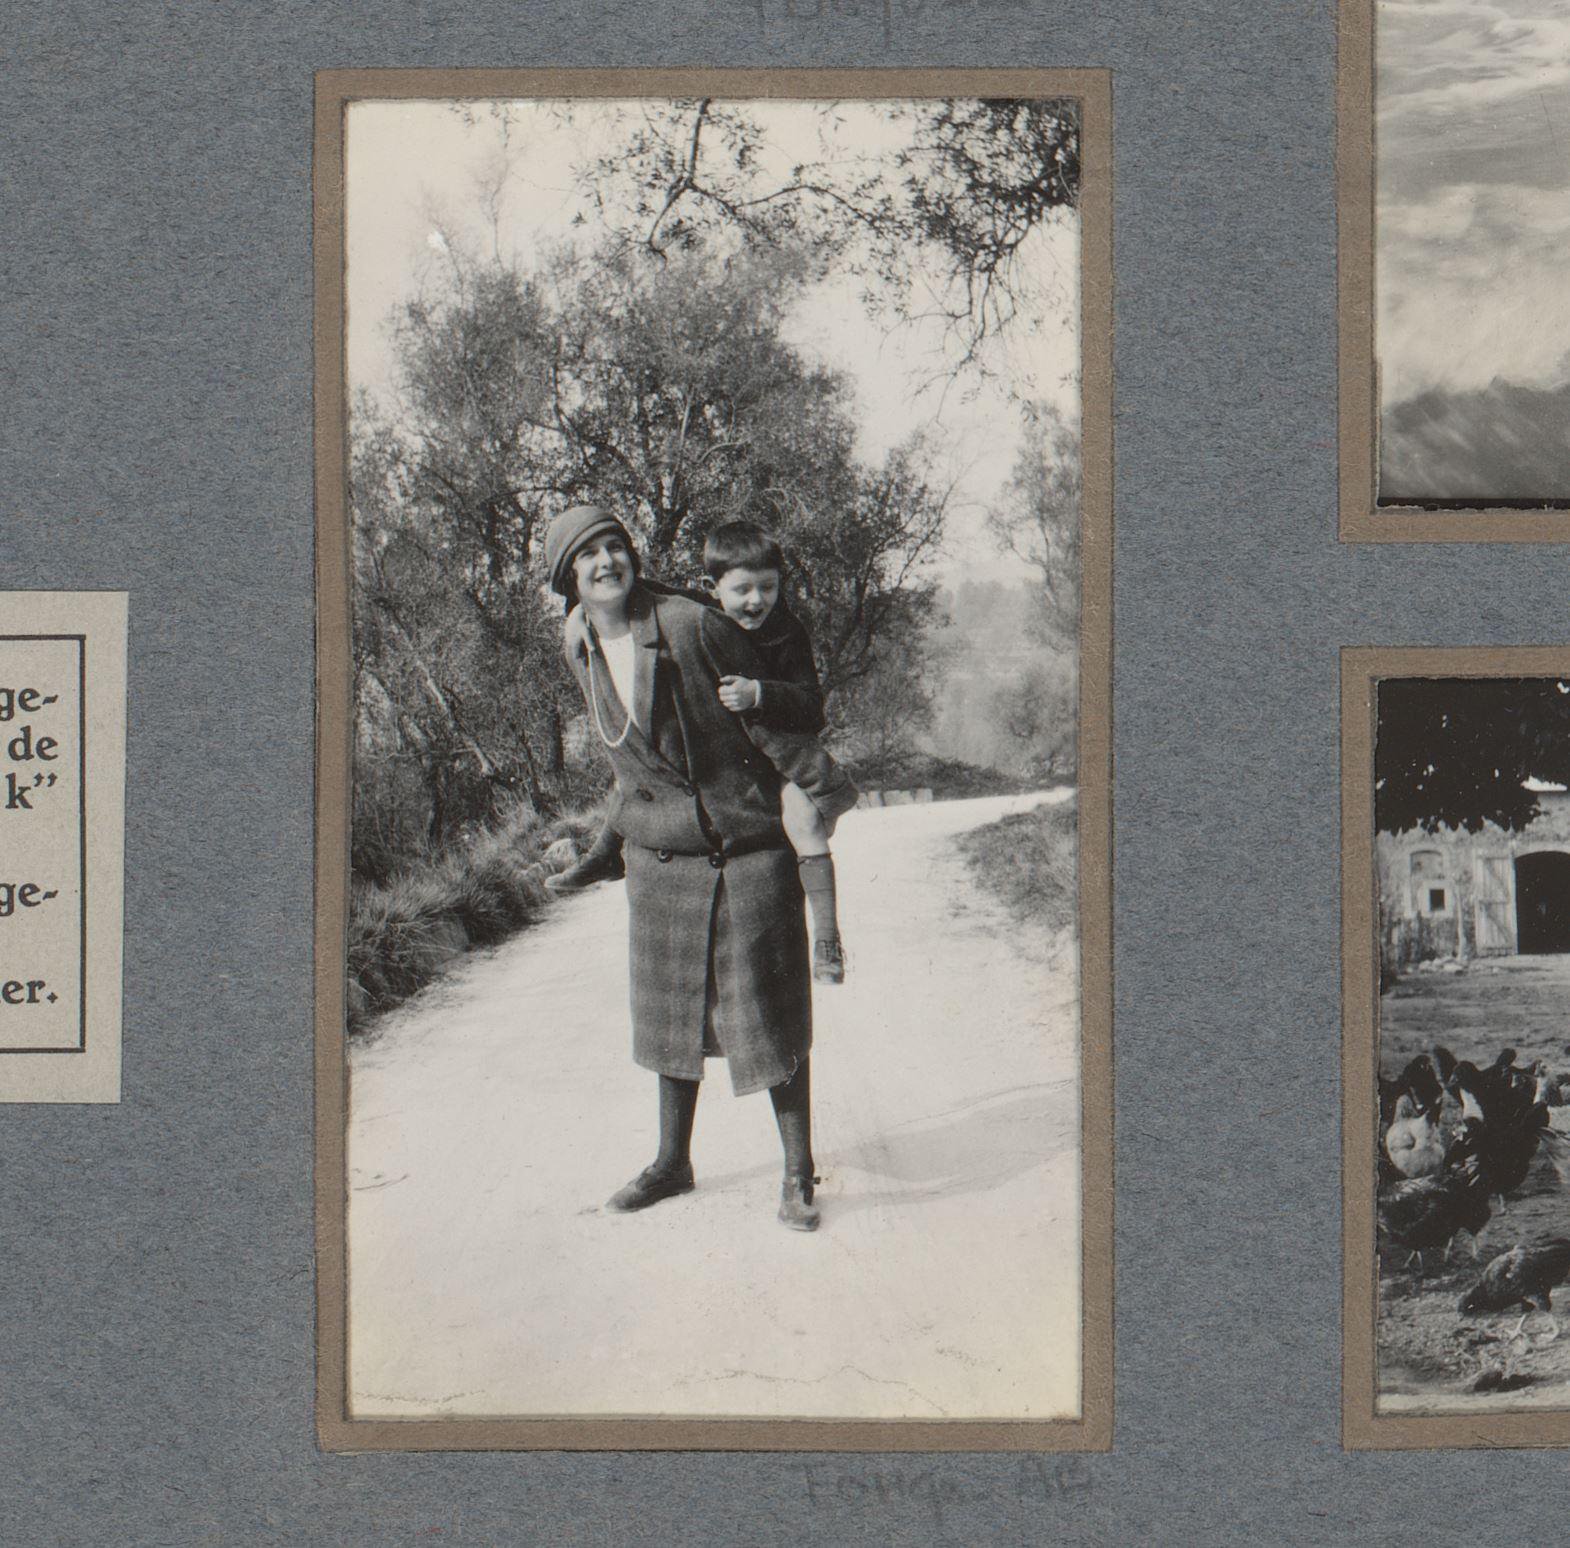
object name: album leaf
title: Moeder met zoon op haar rug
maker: Anonymous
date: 1926-1932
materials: photographic support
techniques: gelatin silver print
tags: forest path or lane, mother with son(s) (mother-love)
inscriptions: inscription: ‘Opnamen gemaakt met de Zak-"Kodak"No. 1a./ Afdrukken gemaakt op "Velox" papier.’